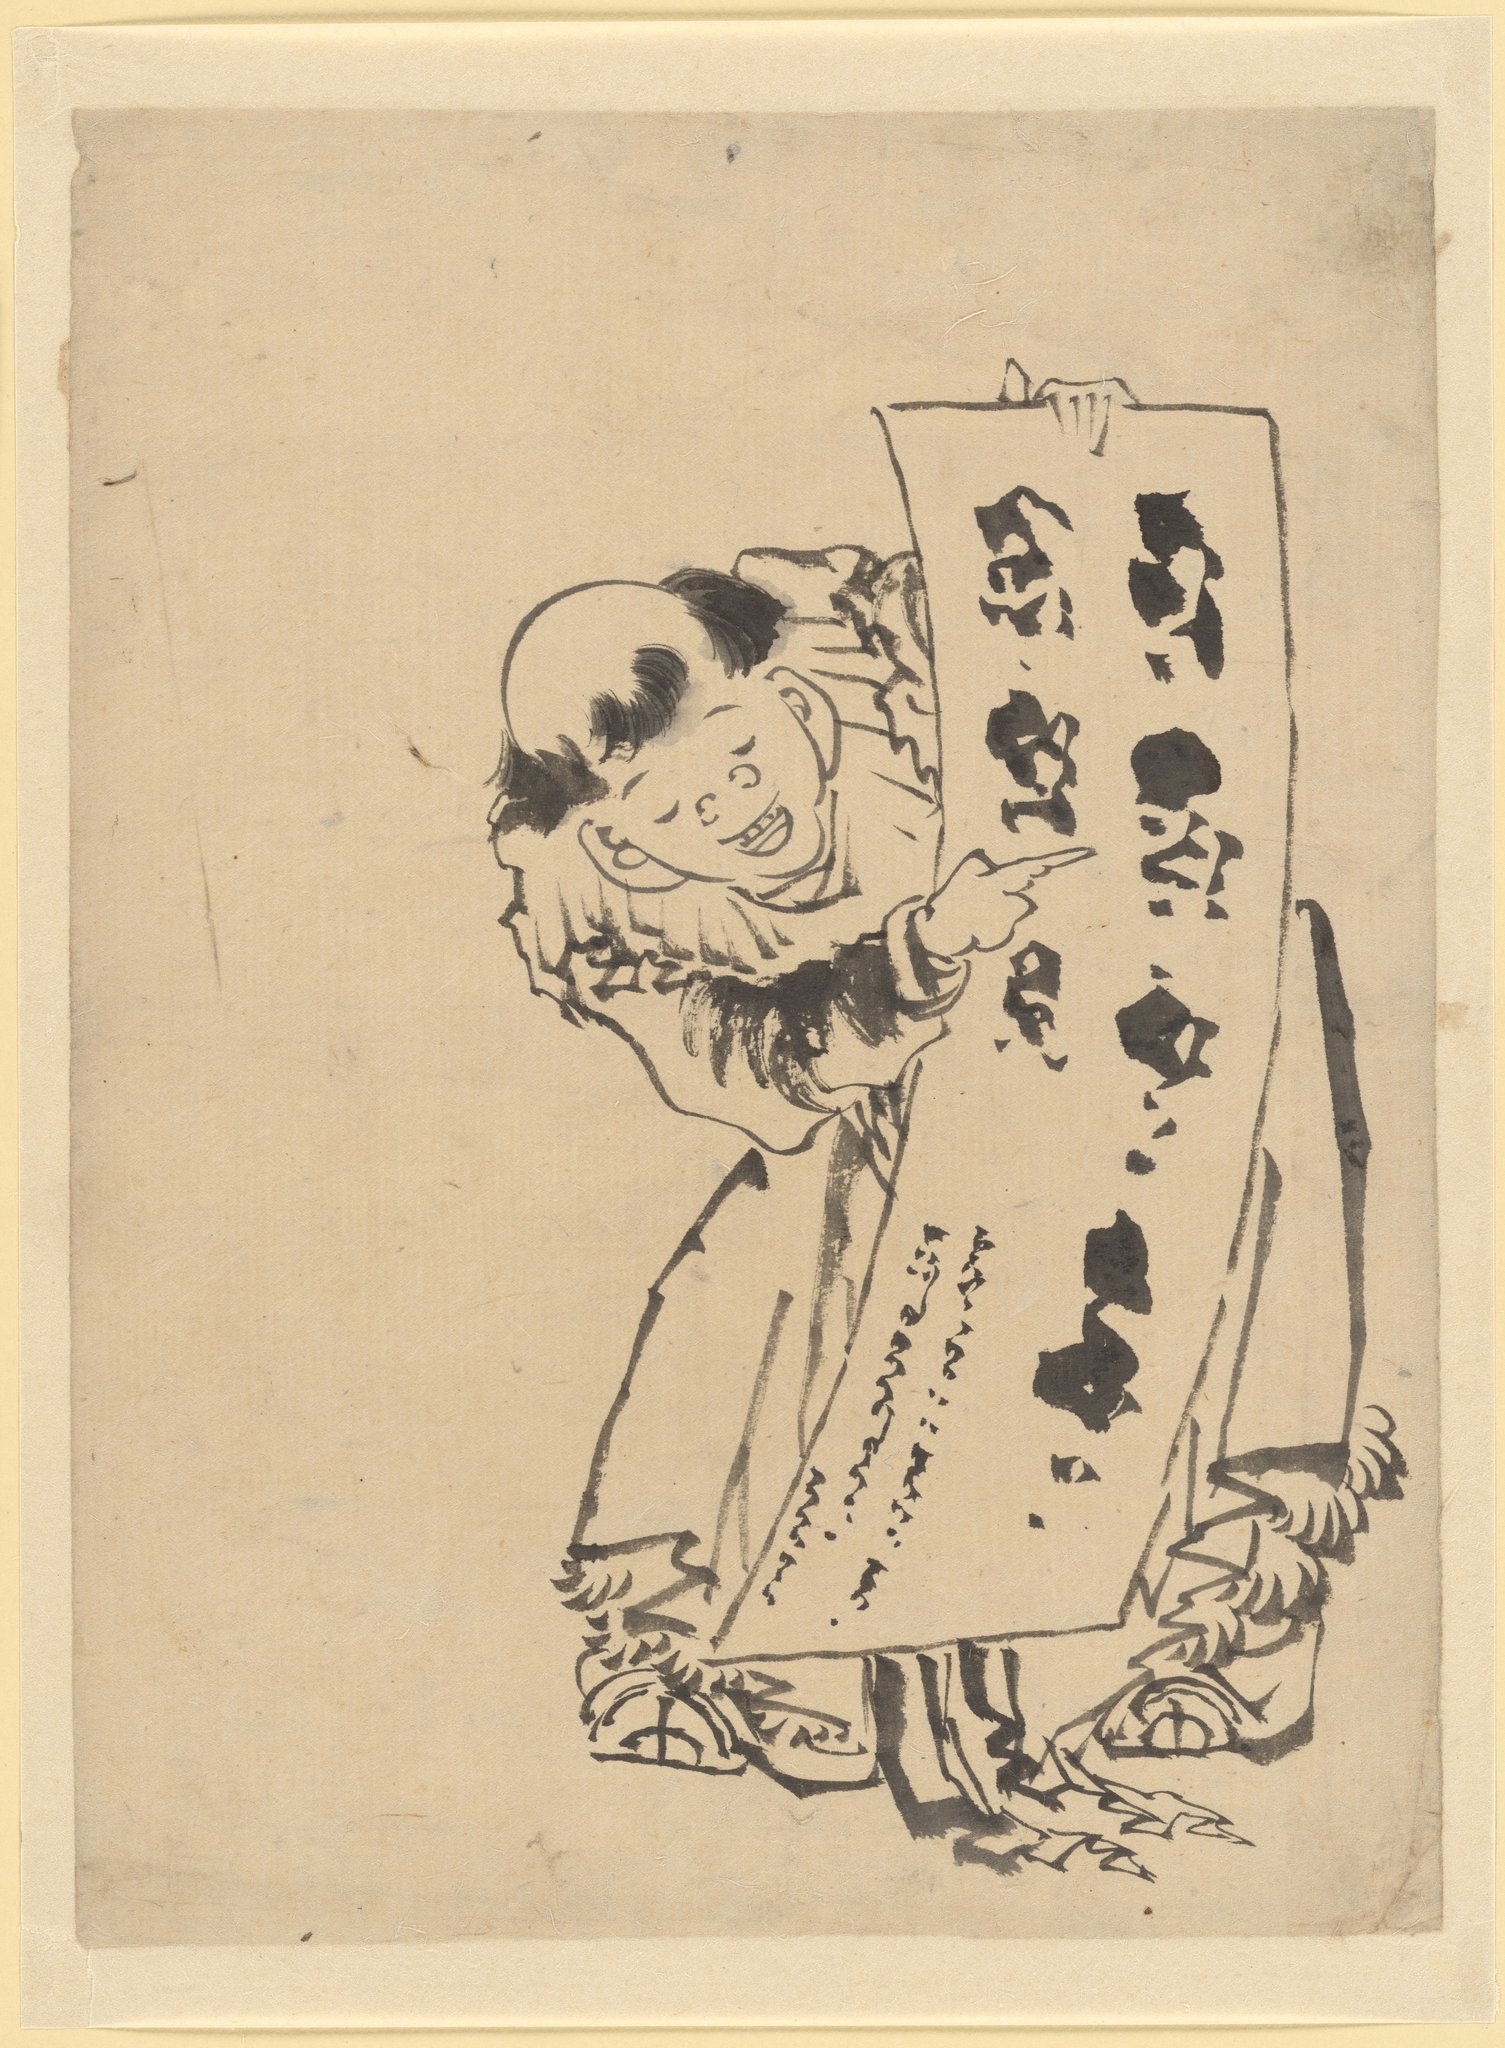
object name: drawing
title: Chinese Boy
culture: japanese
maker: katsushika hokusai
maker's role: artist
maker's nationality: japanese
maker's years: 1760-1849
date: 1701-1900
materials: ink, paper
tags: boys